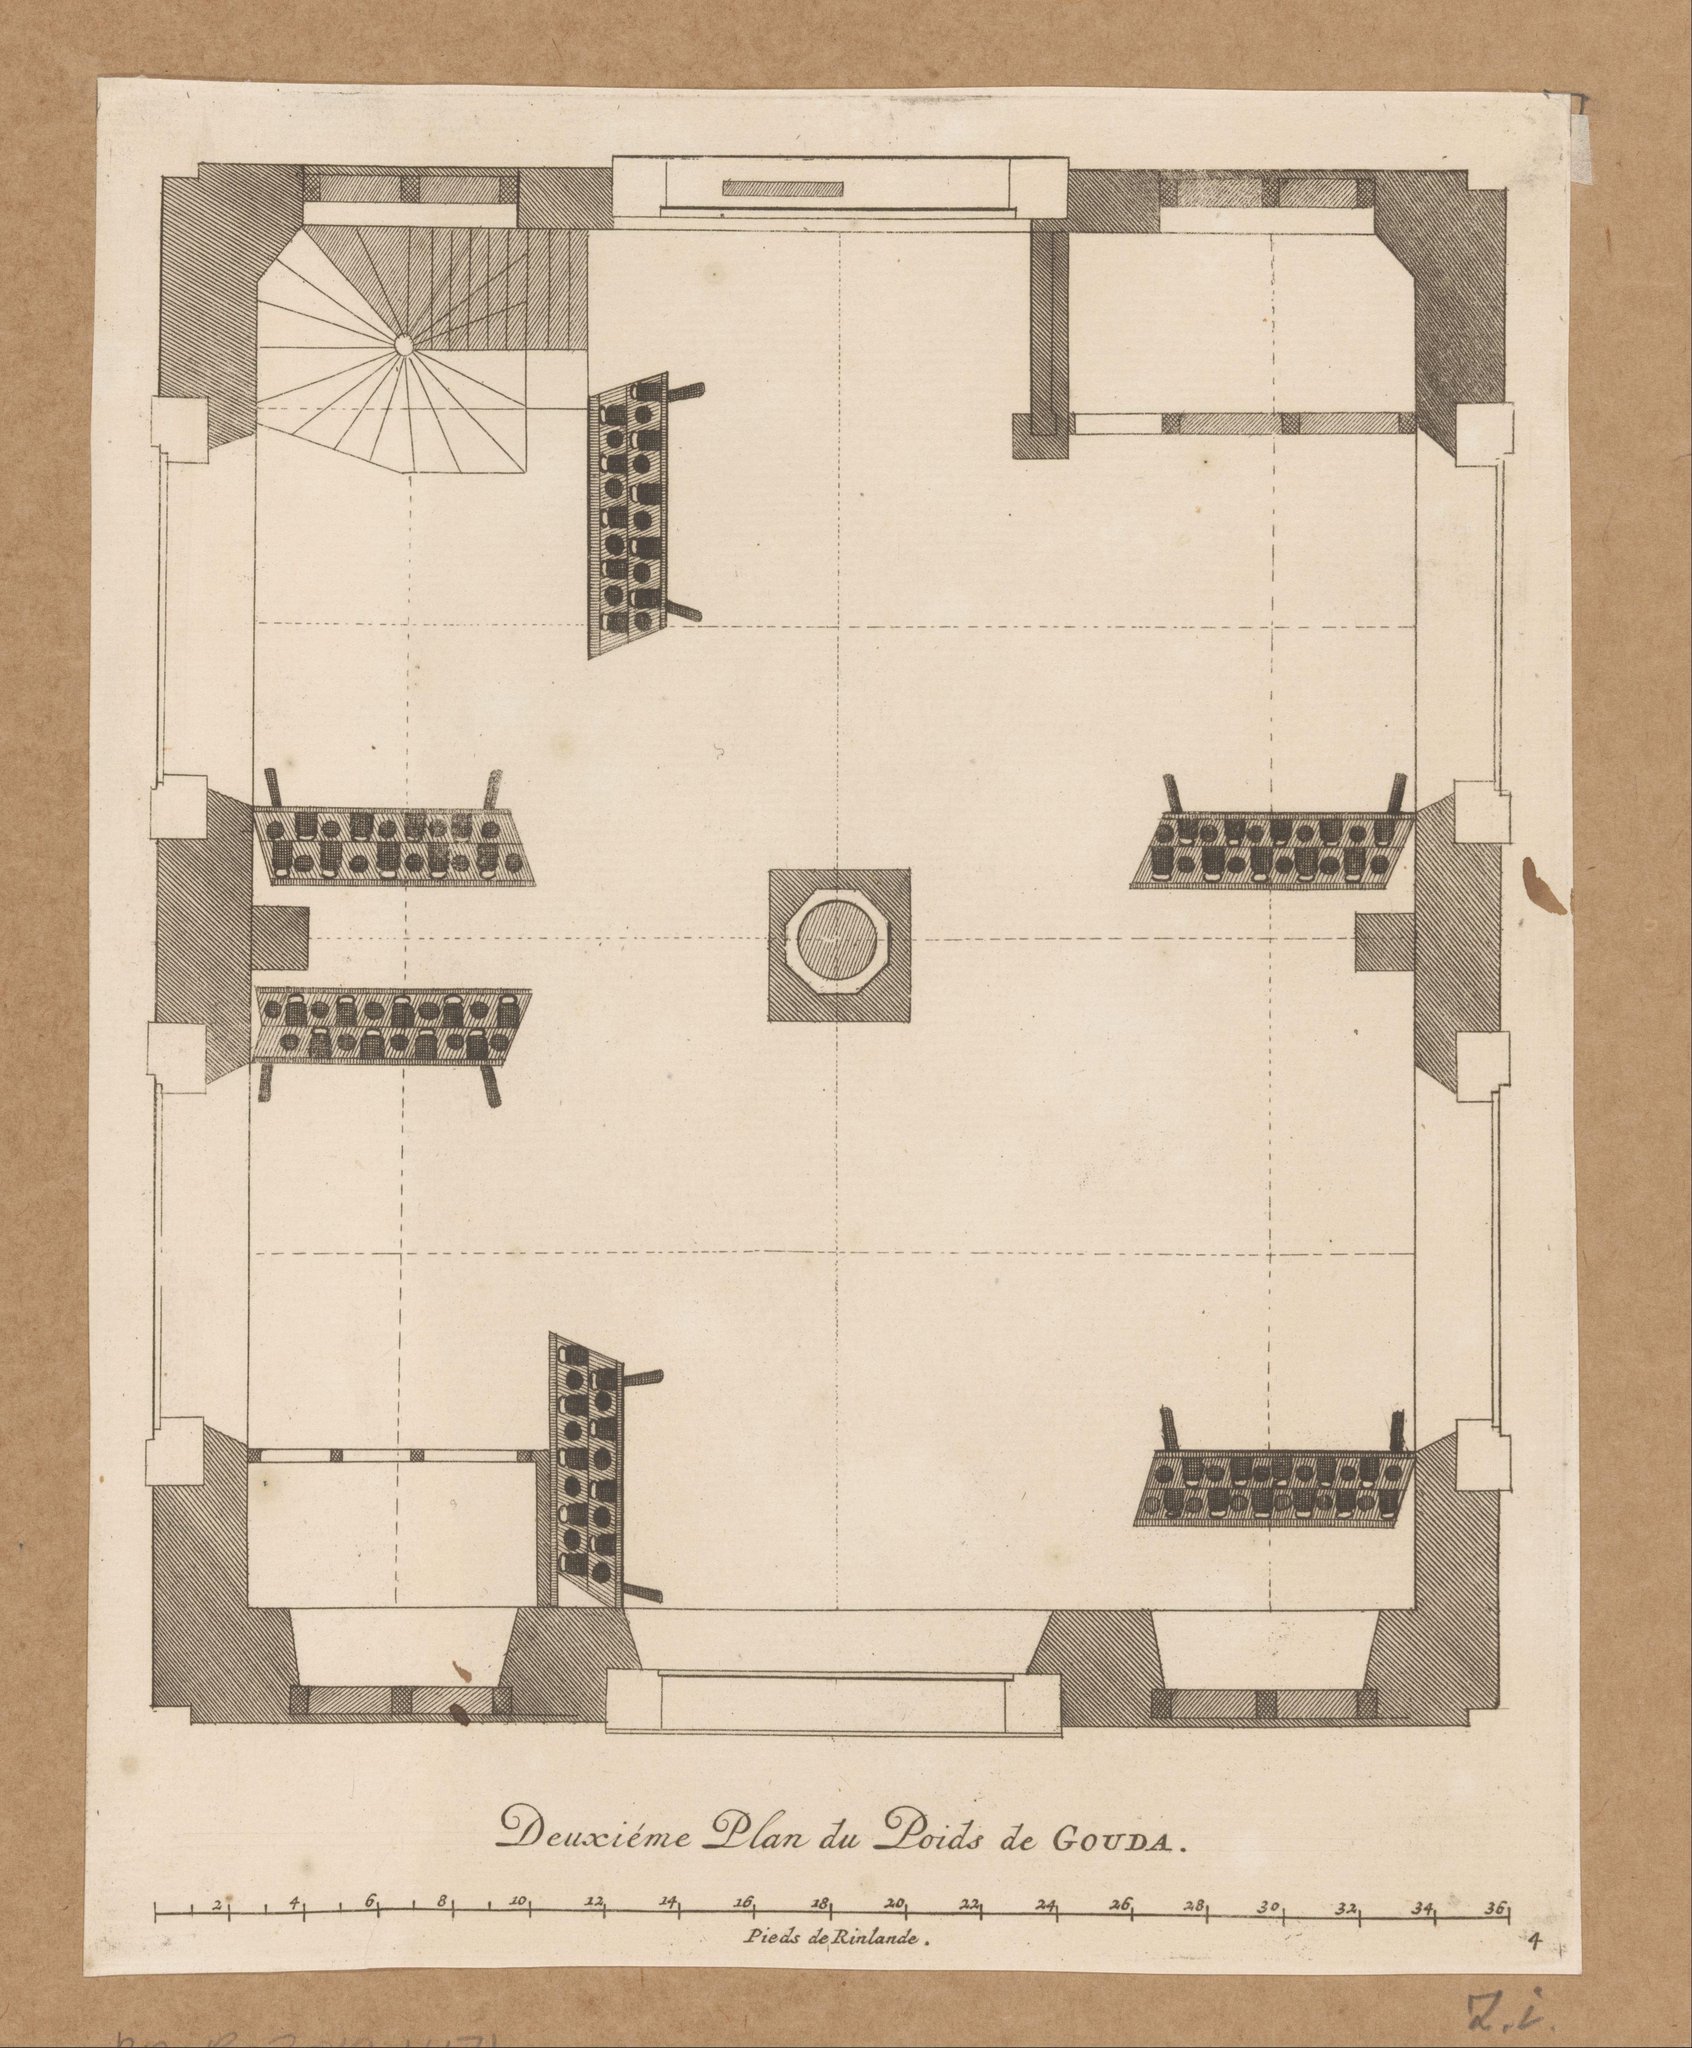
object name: area plan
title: Deuxiéme Plan du Poids de Gouda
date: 1715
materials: paper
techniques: etching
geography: leiden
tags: plan ~ architecture, weigh-house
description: Prent uit: Les Ouvrages d'Architecture ordonnez par Pierre Post (...). Leiden: Pieter van der Aa, 1705.